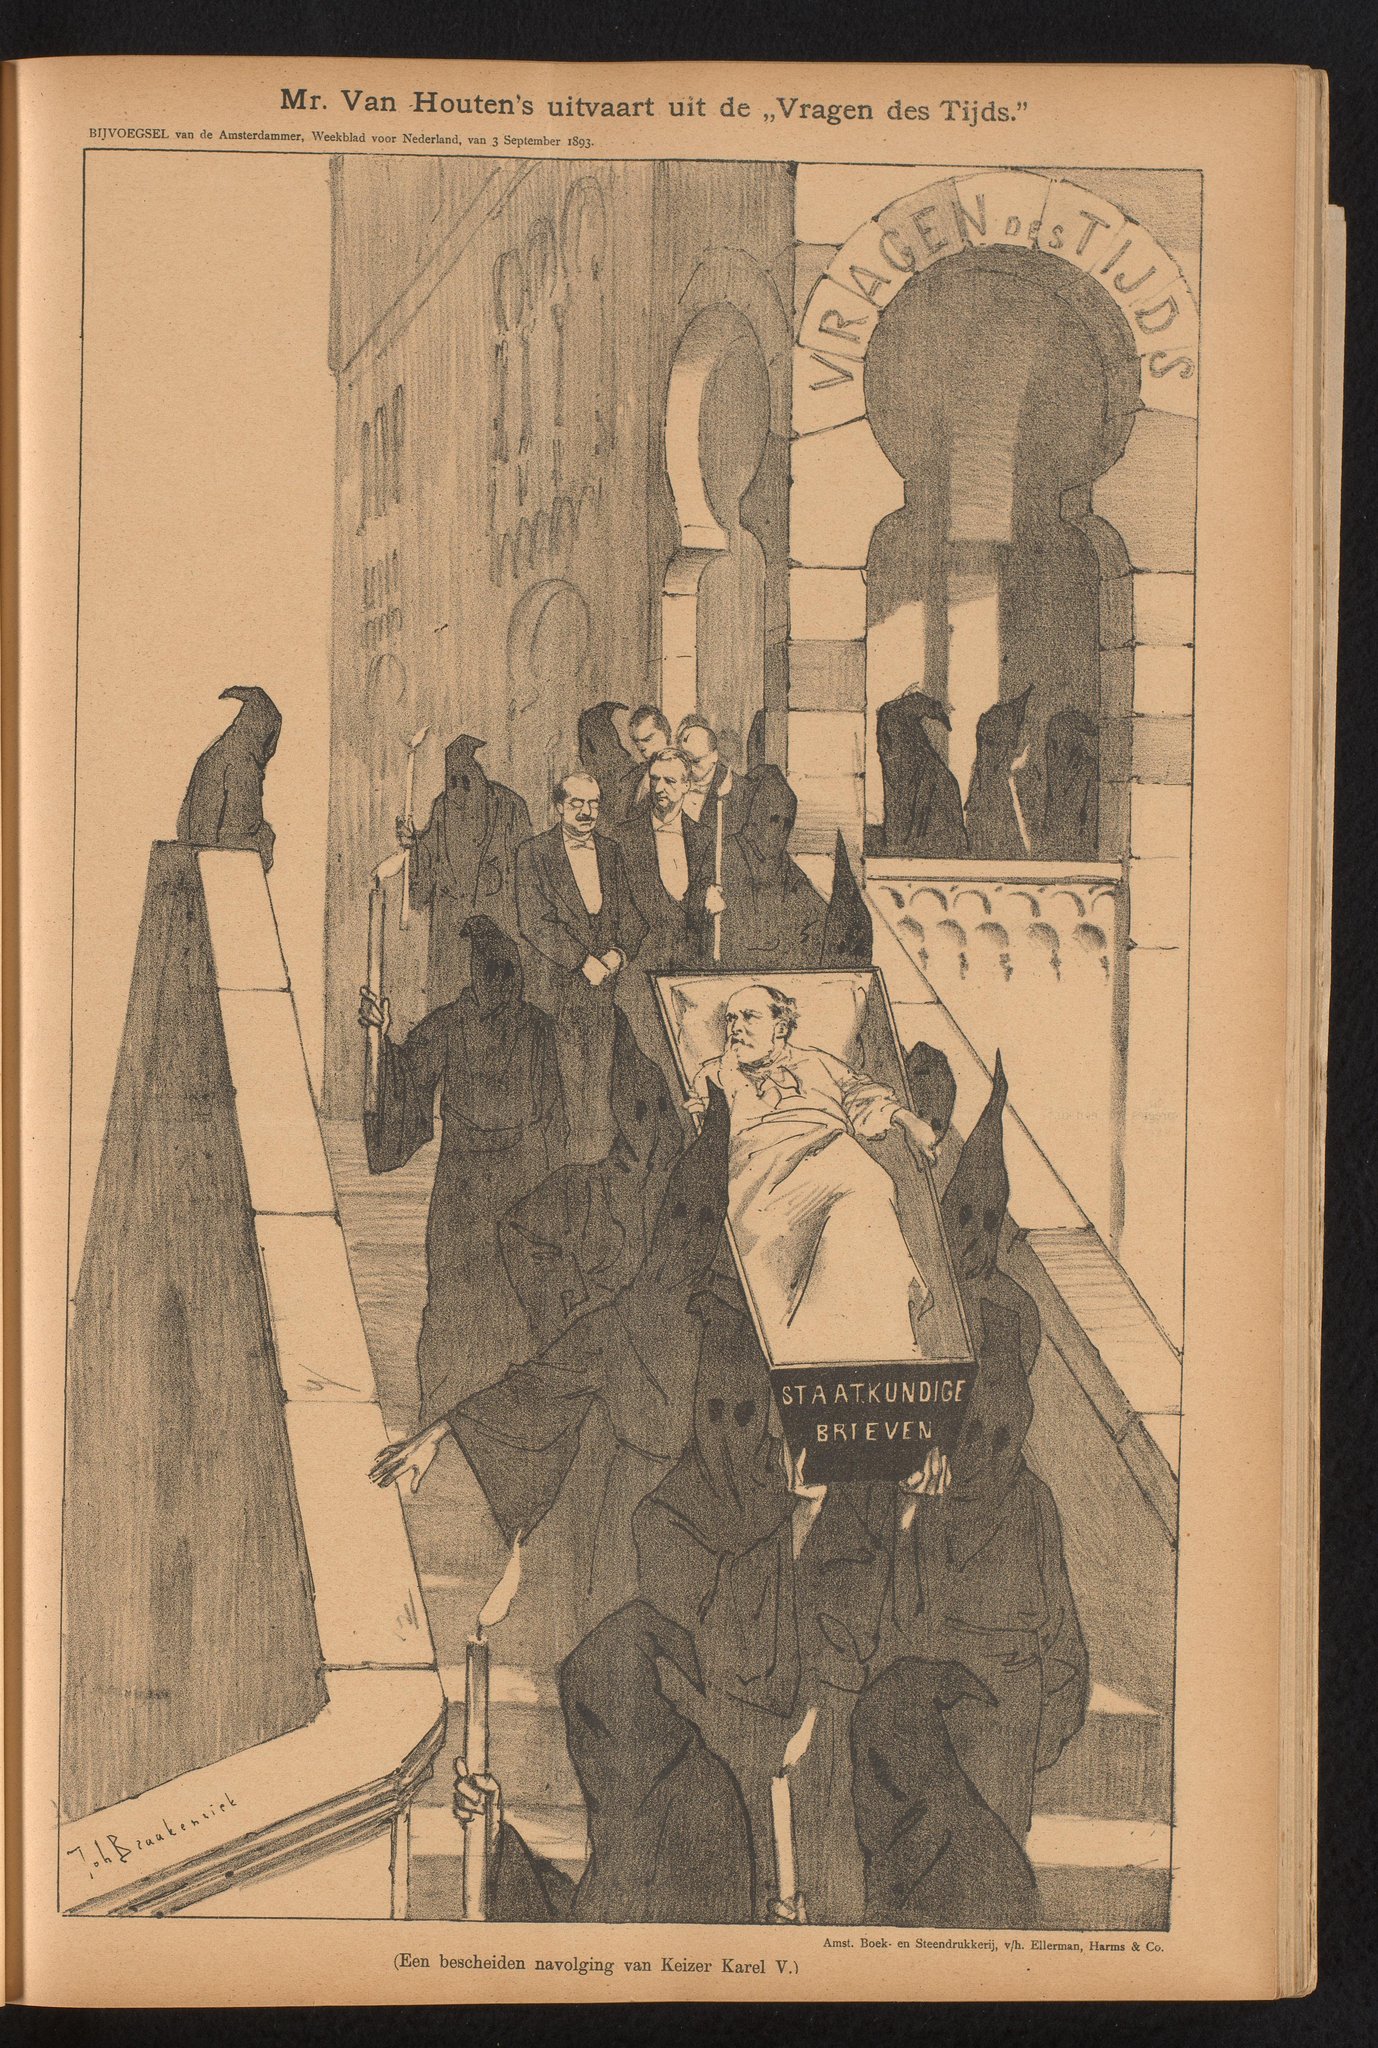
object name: cartoon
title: Mr. Van Houten's uitvaart uit de "Vragen des Tijds."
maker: johan braakensiek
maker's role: draughtsman, print maker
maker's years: 1858-1940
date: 1893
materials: paper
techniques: lithograph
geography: amsterdam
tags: the hague, politician, samuel van houten, cortege, funeral procession, procession ~ christian religion, political caricatures and satires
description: Tweede Kamerlid Sam van Houten wordt in een open kist 'staatkundige brieven' de kerk 'Vragen des Tijds' uitgedragen door personen in mantels en puntmutsen (penitentes).